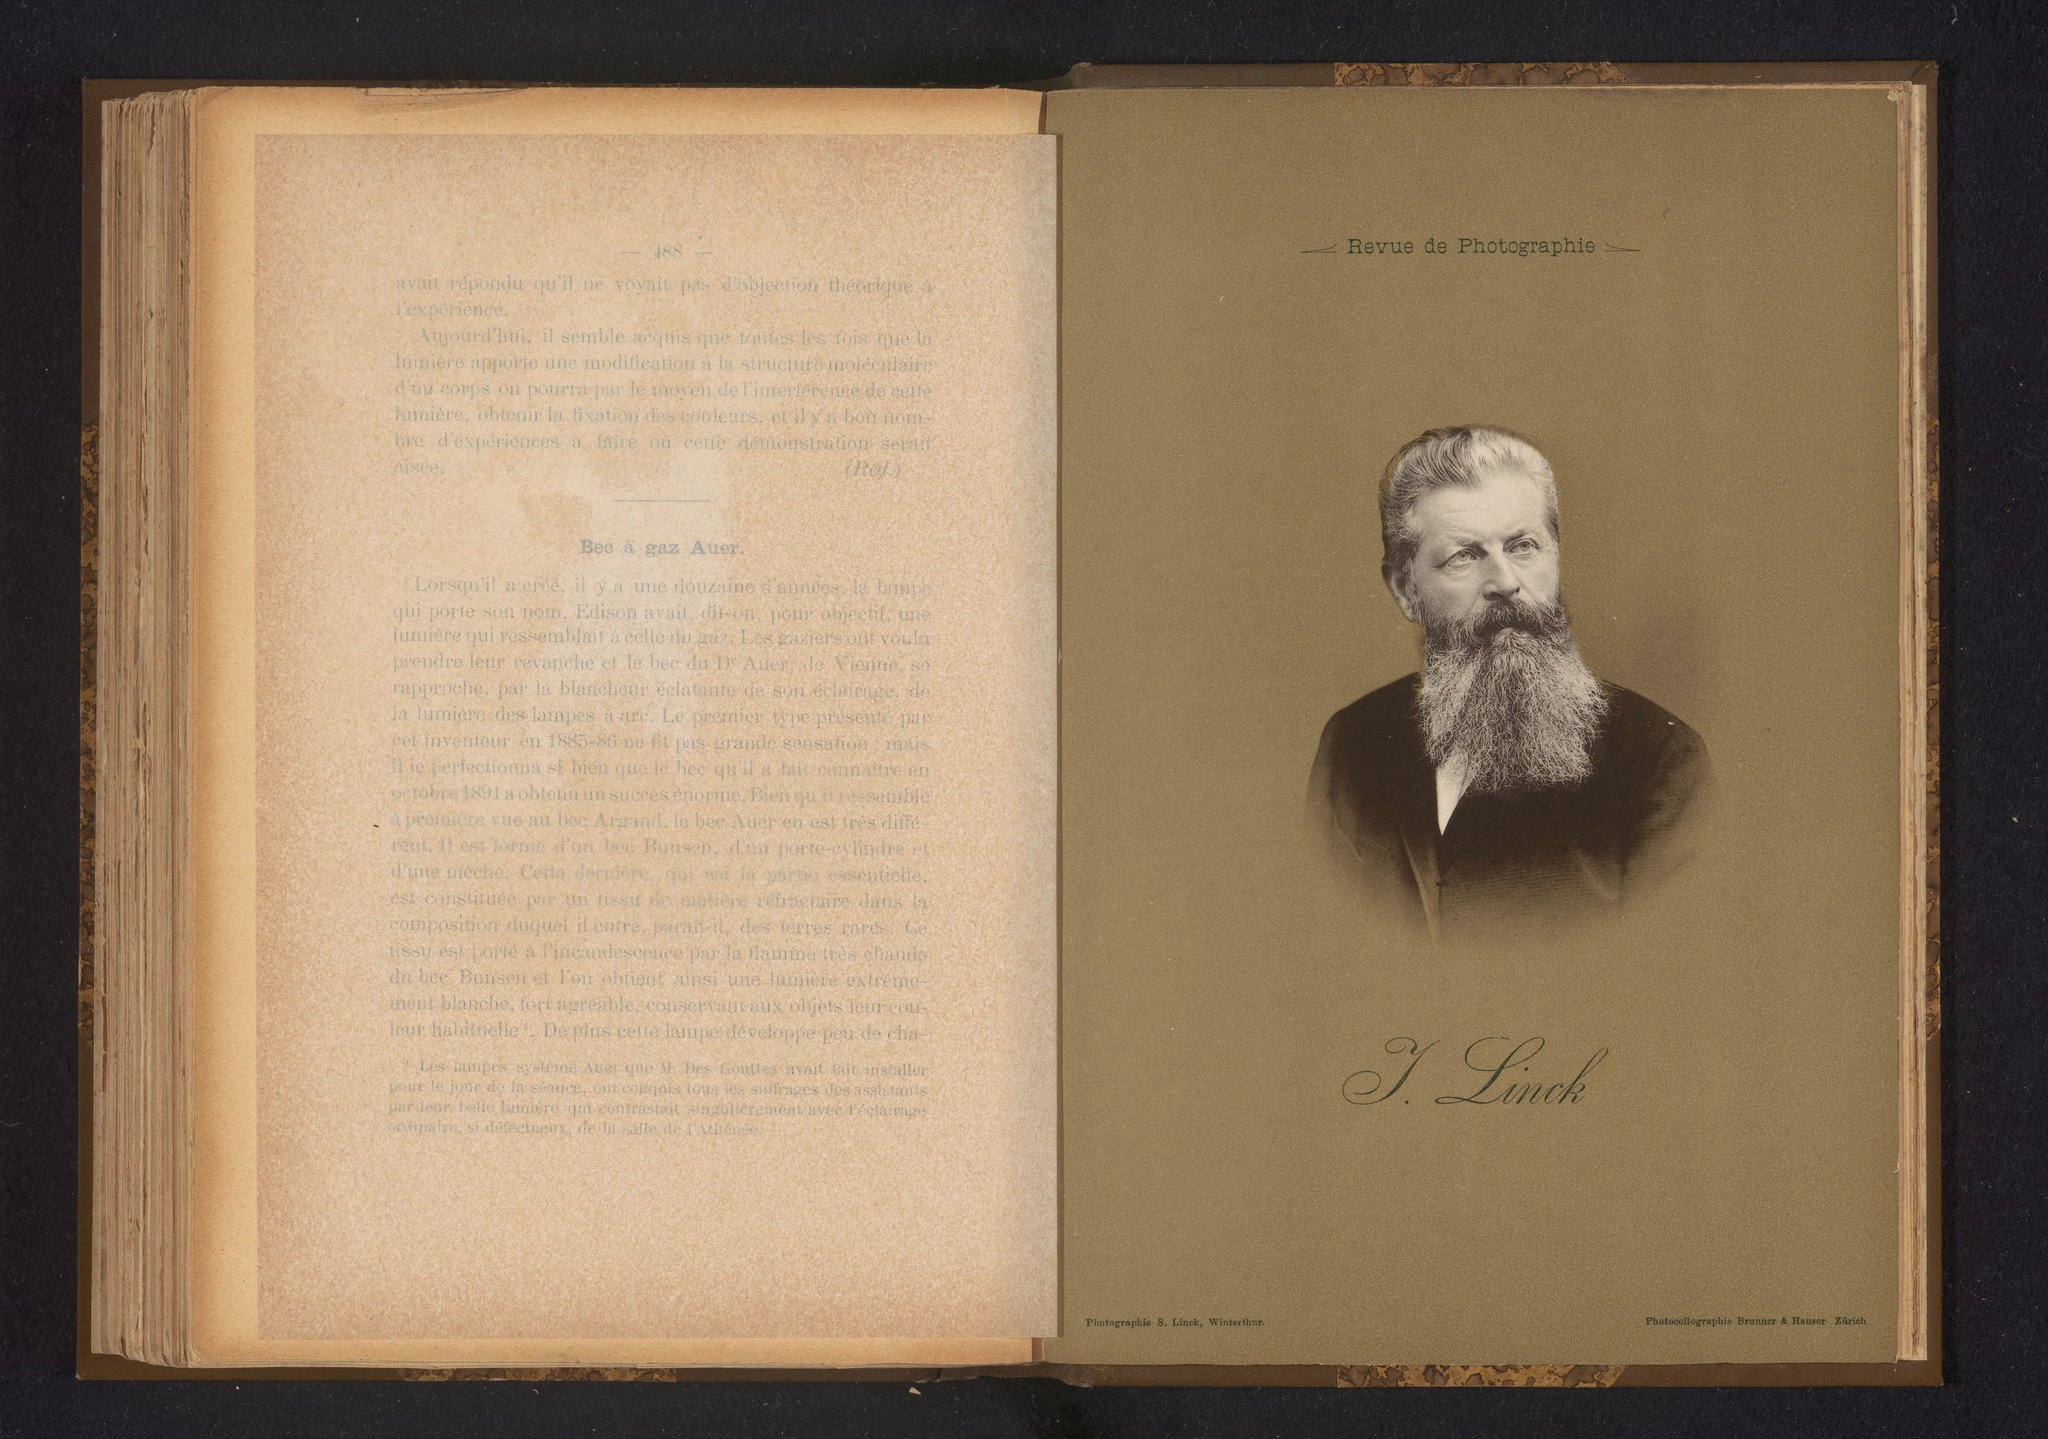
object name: photomechanical print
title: Portret van een onbekende man, mogelijk J. Linck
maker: s. linck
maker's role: fotograaf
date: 1887-1892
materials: paper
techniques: photograph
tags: adult man, historical persons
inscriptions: inscription: ‘J. Linck’